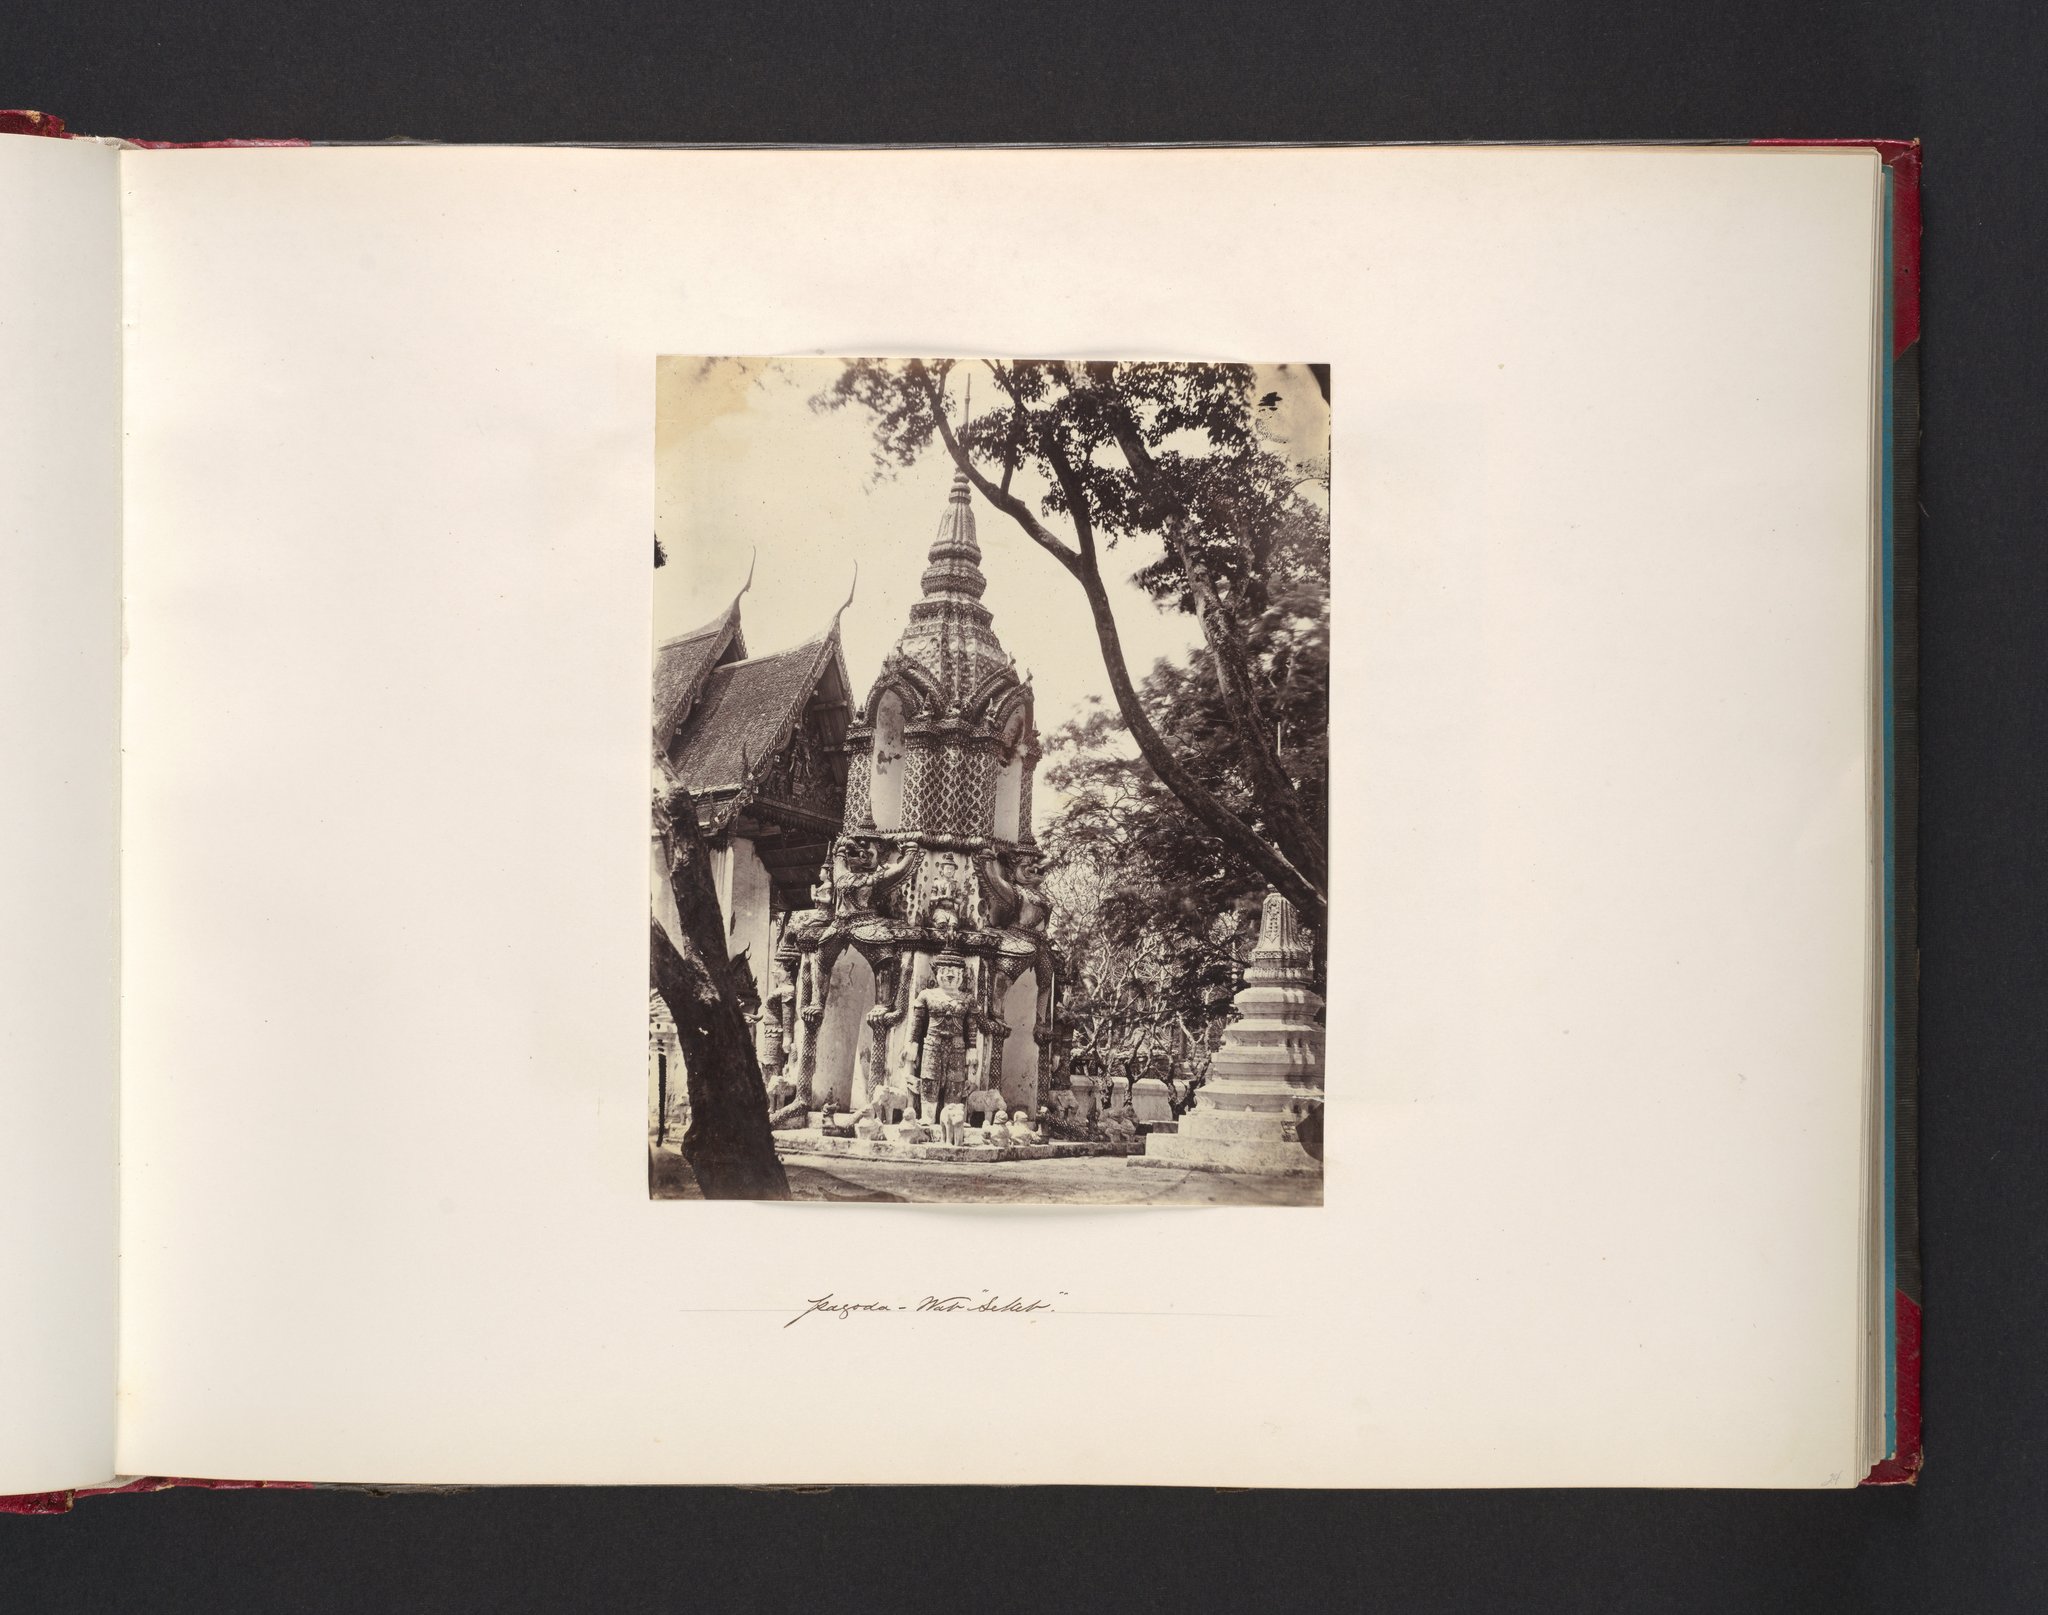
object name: photograph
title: Pagoda - Wat "Seket"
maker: john thomson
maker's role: artist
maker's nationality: british, scottish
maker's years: 1837-1921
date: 1865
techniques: albumen silver print, glass negative